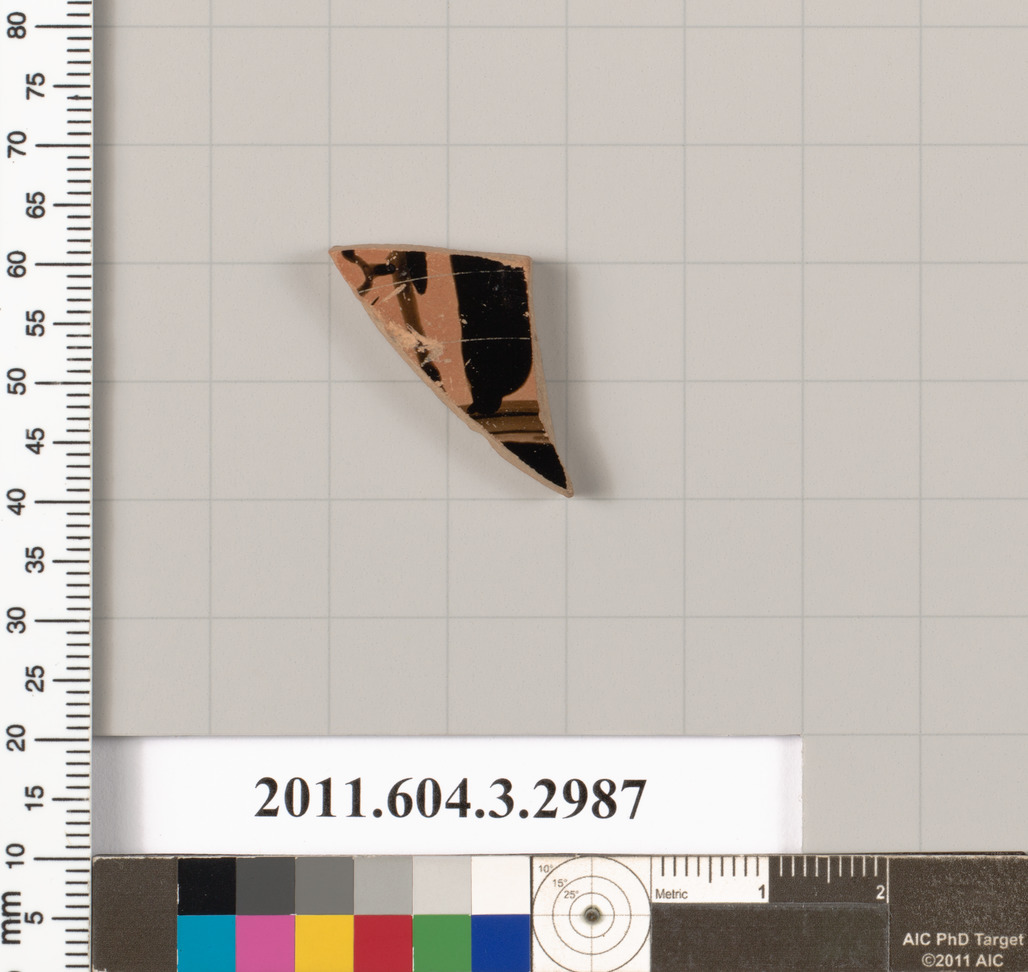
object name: undetermined open shape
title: Terracotta fragment of an open shape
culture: greek, attic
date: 600-501 BCE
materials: terracotta